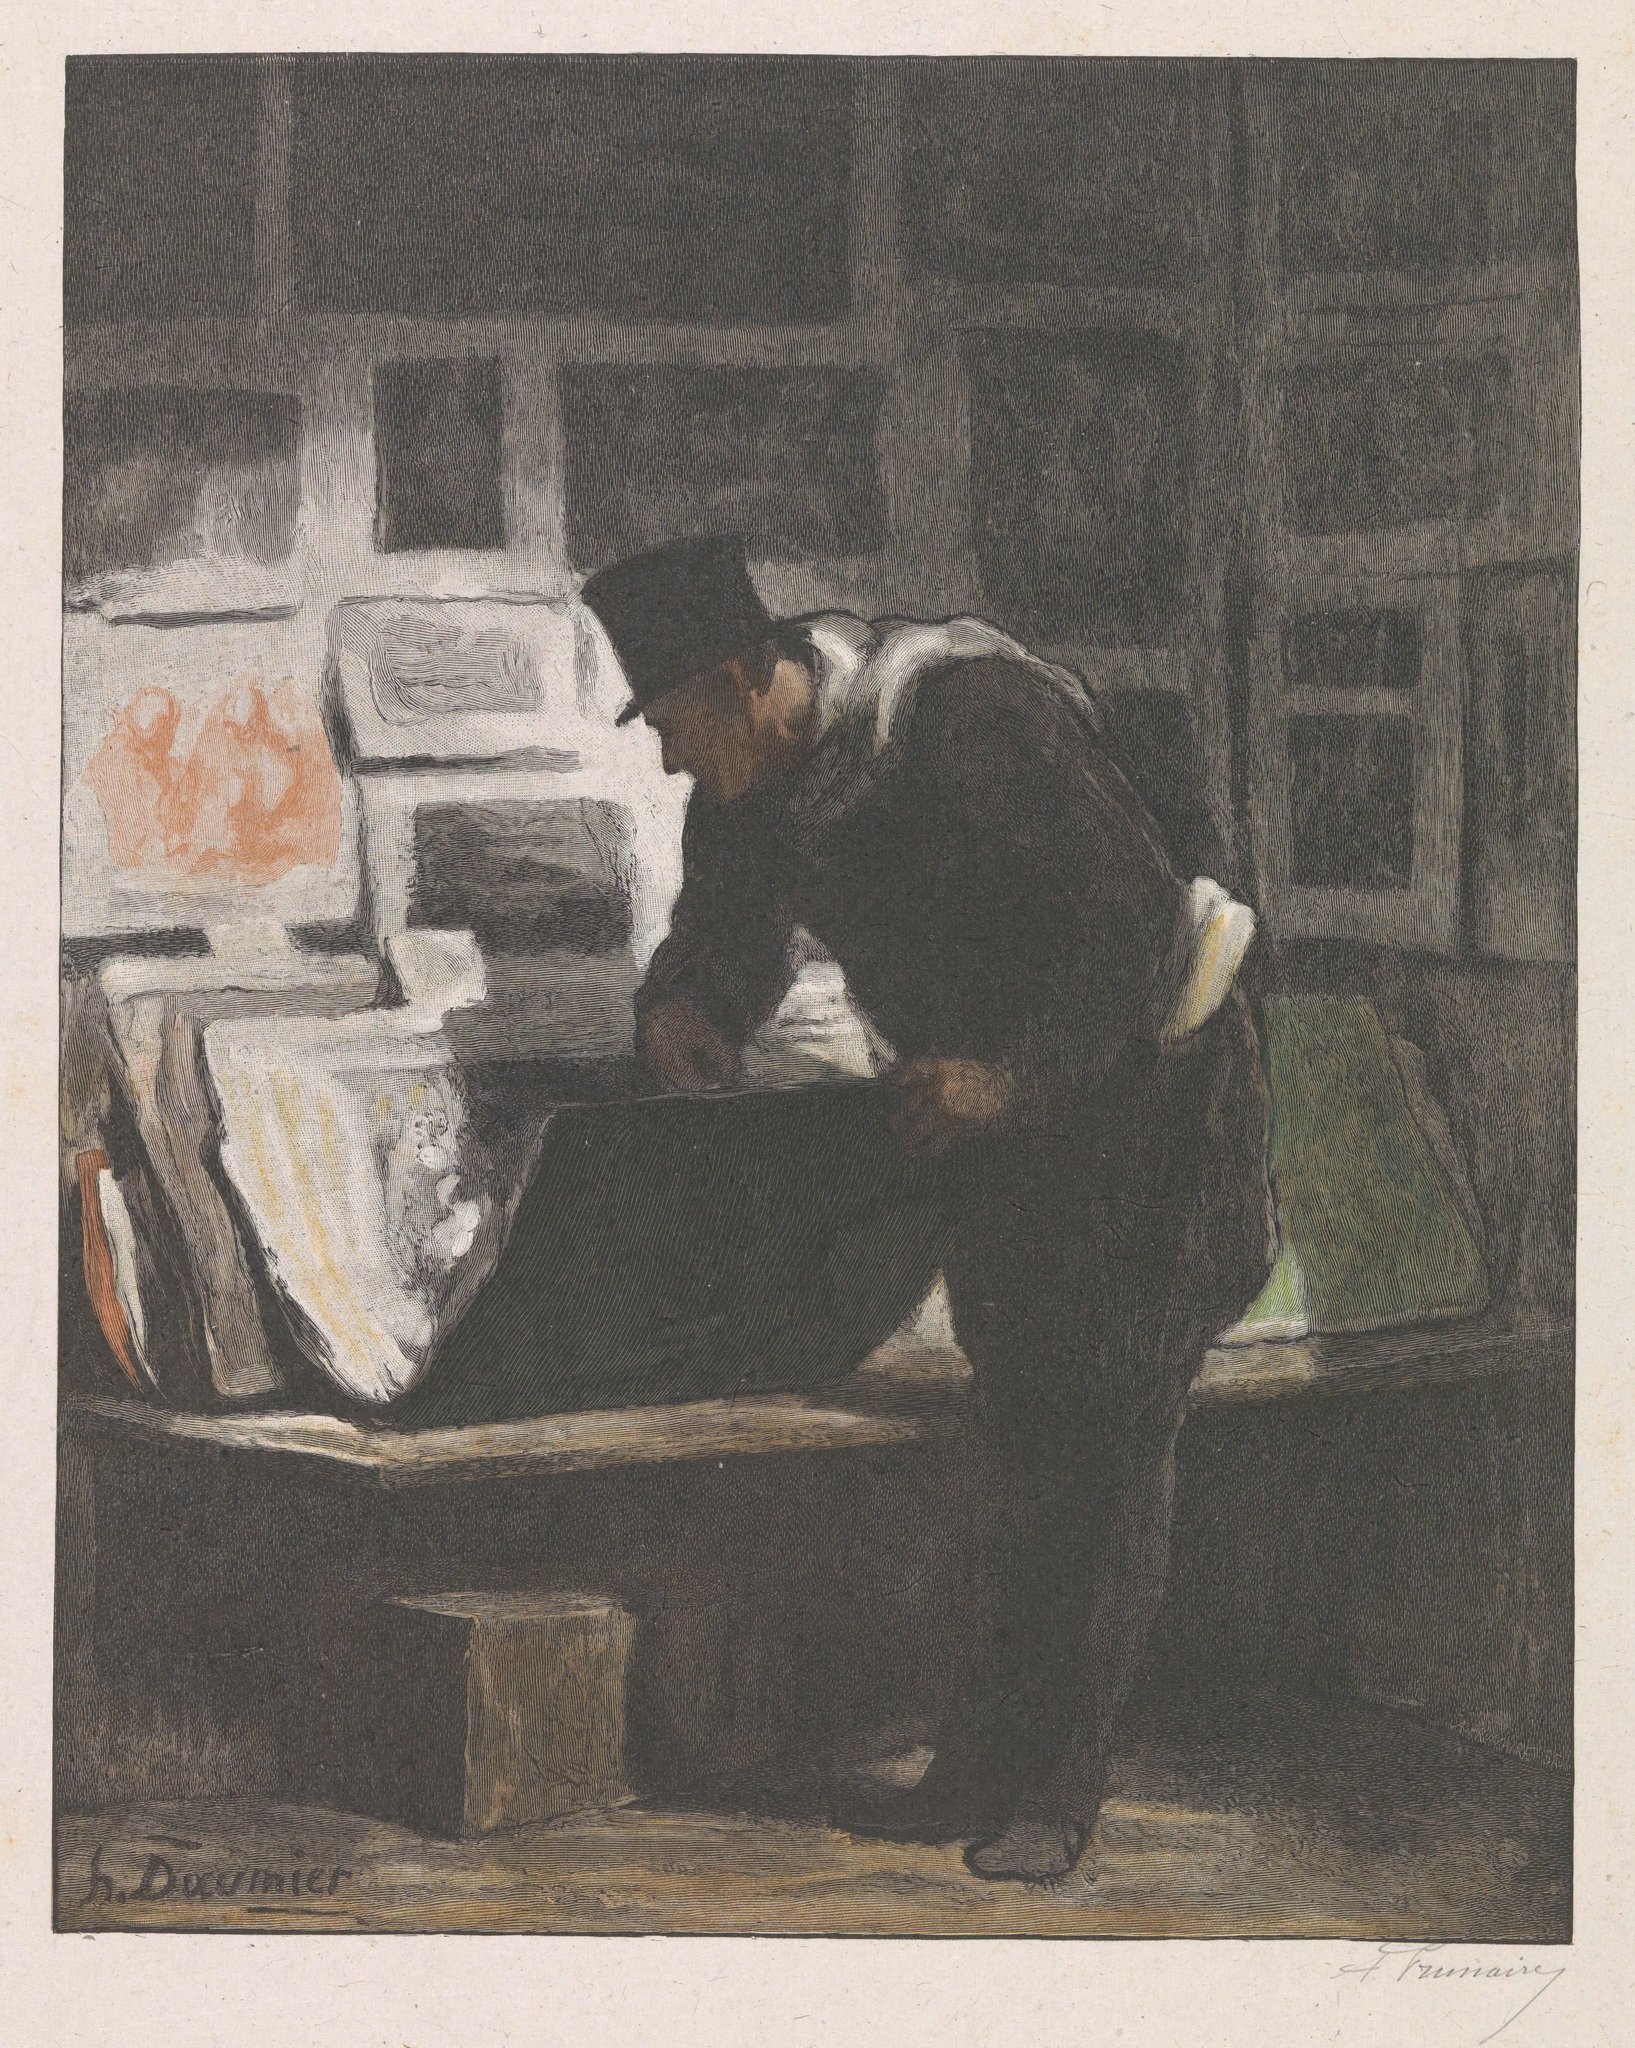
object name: print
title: Verzamelaar van prenten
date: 1860-1902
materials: paper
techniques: wood engraving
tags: print, e.g.: engraving, etching, lithograph, art collector (+ graphic arts)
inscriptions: collector's mark: Lugt 2228, collector's mark: Lugt 4779, collector's mark: Lugt 4780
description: Een man met een hoed en een sjaal bladert door een map prenten. Aan de muur hangen prenten.